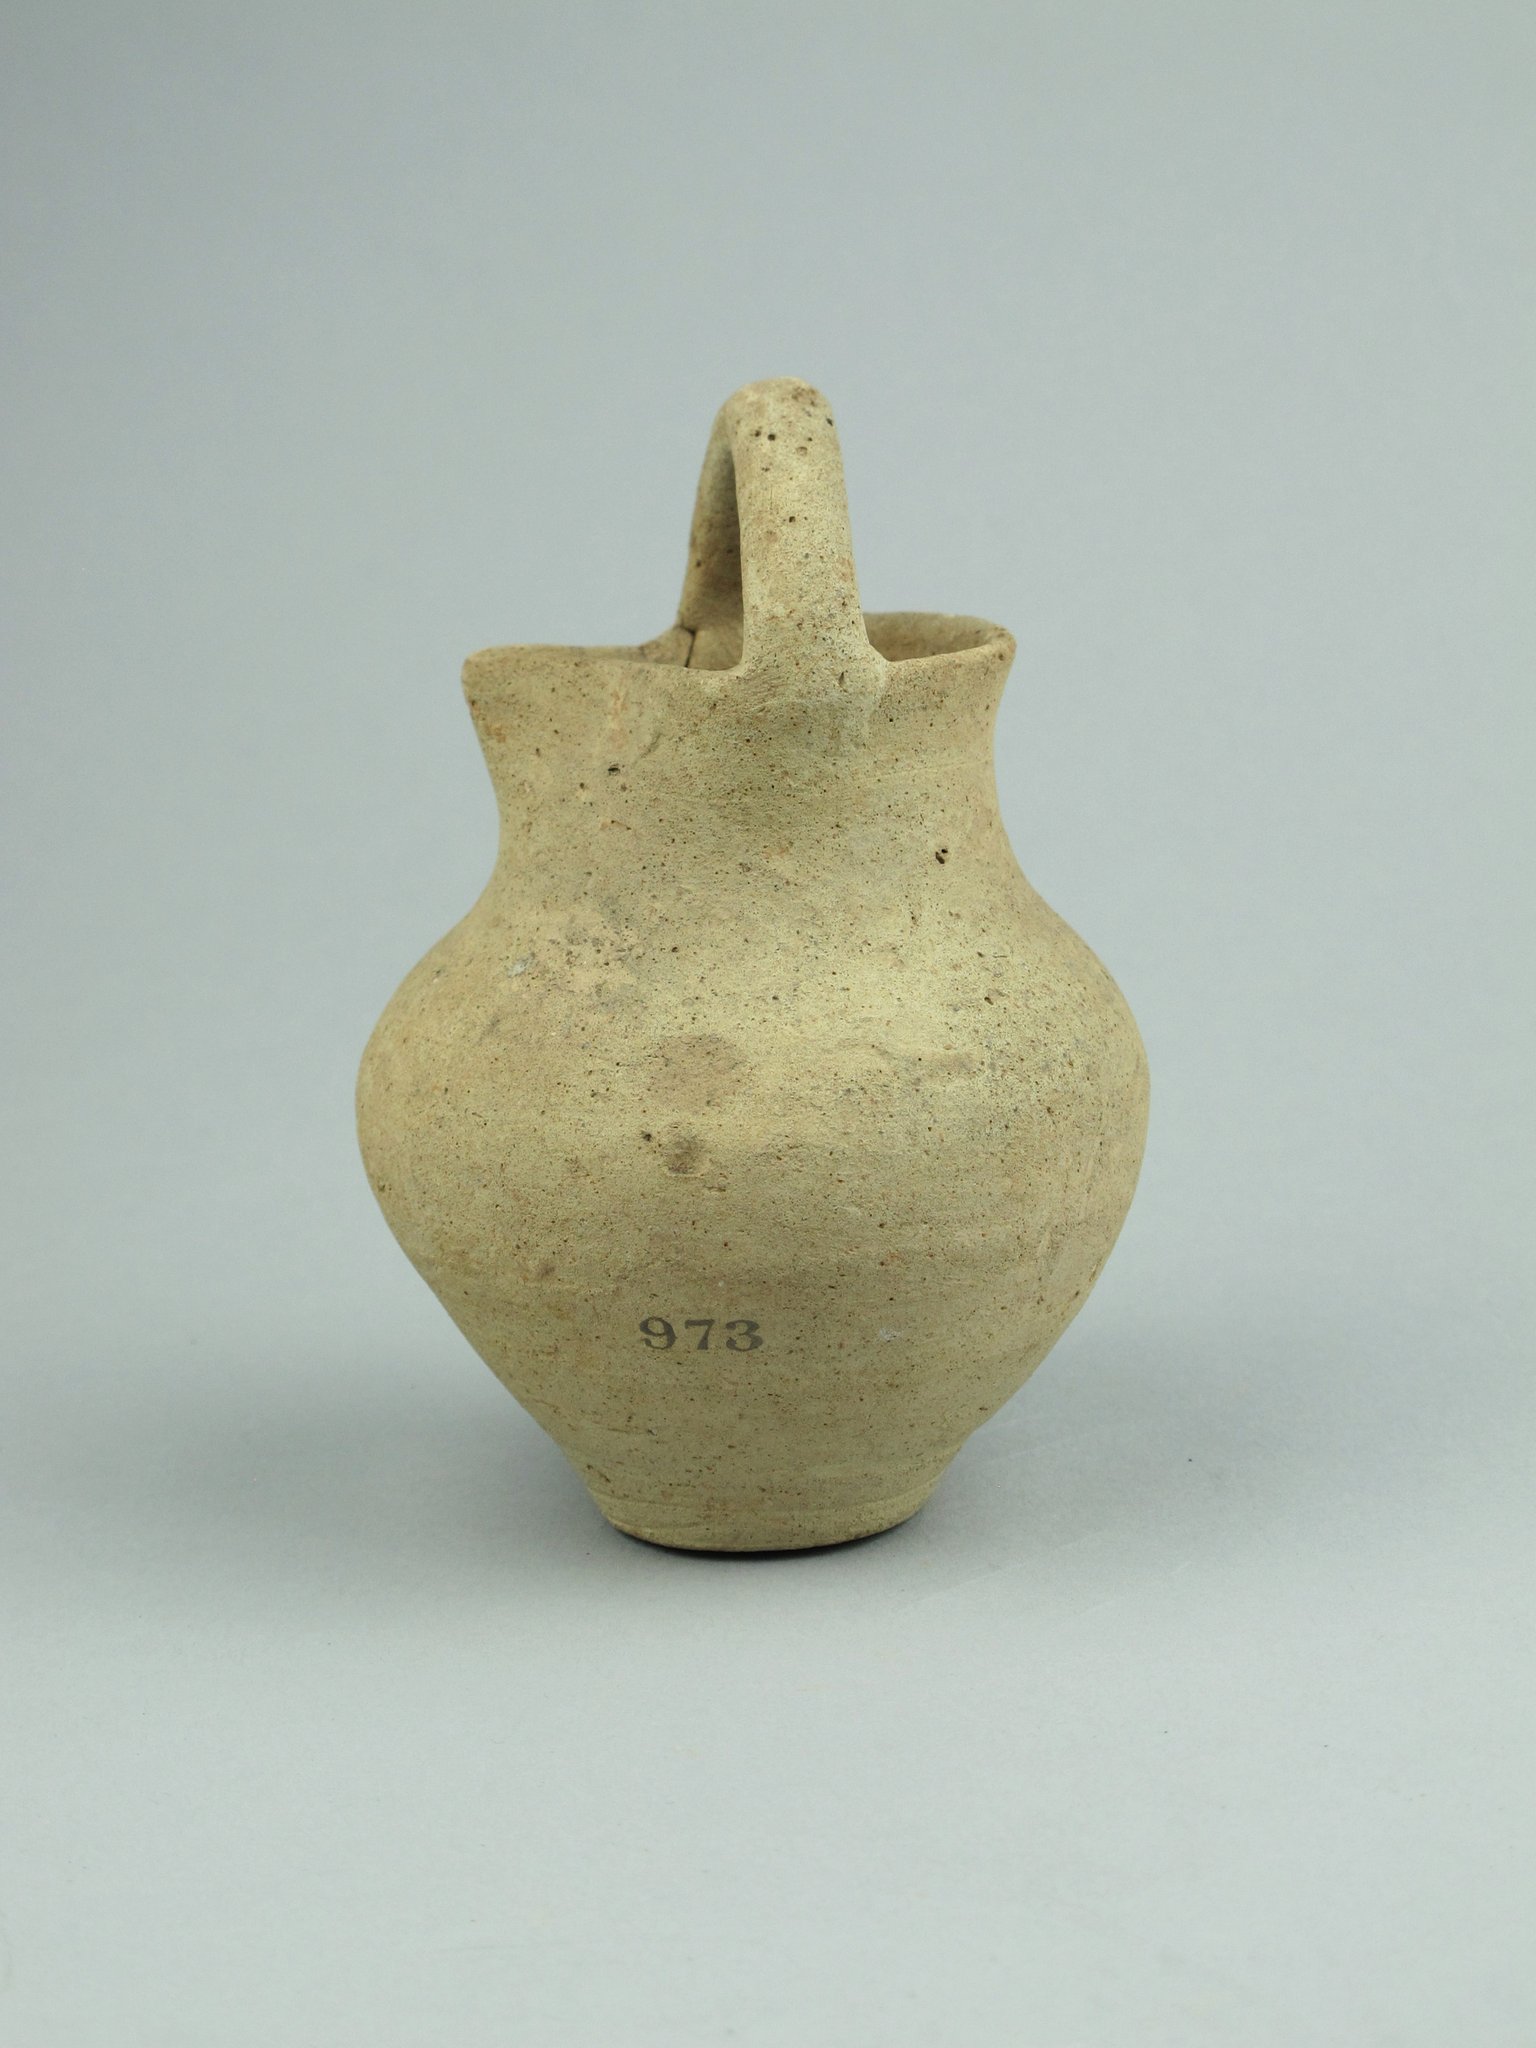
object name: juglet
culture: cypriot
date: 600-480 BCE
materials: terracotta